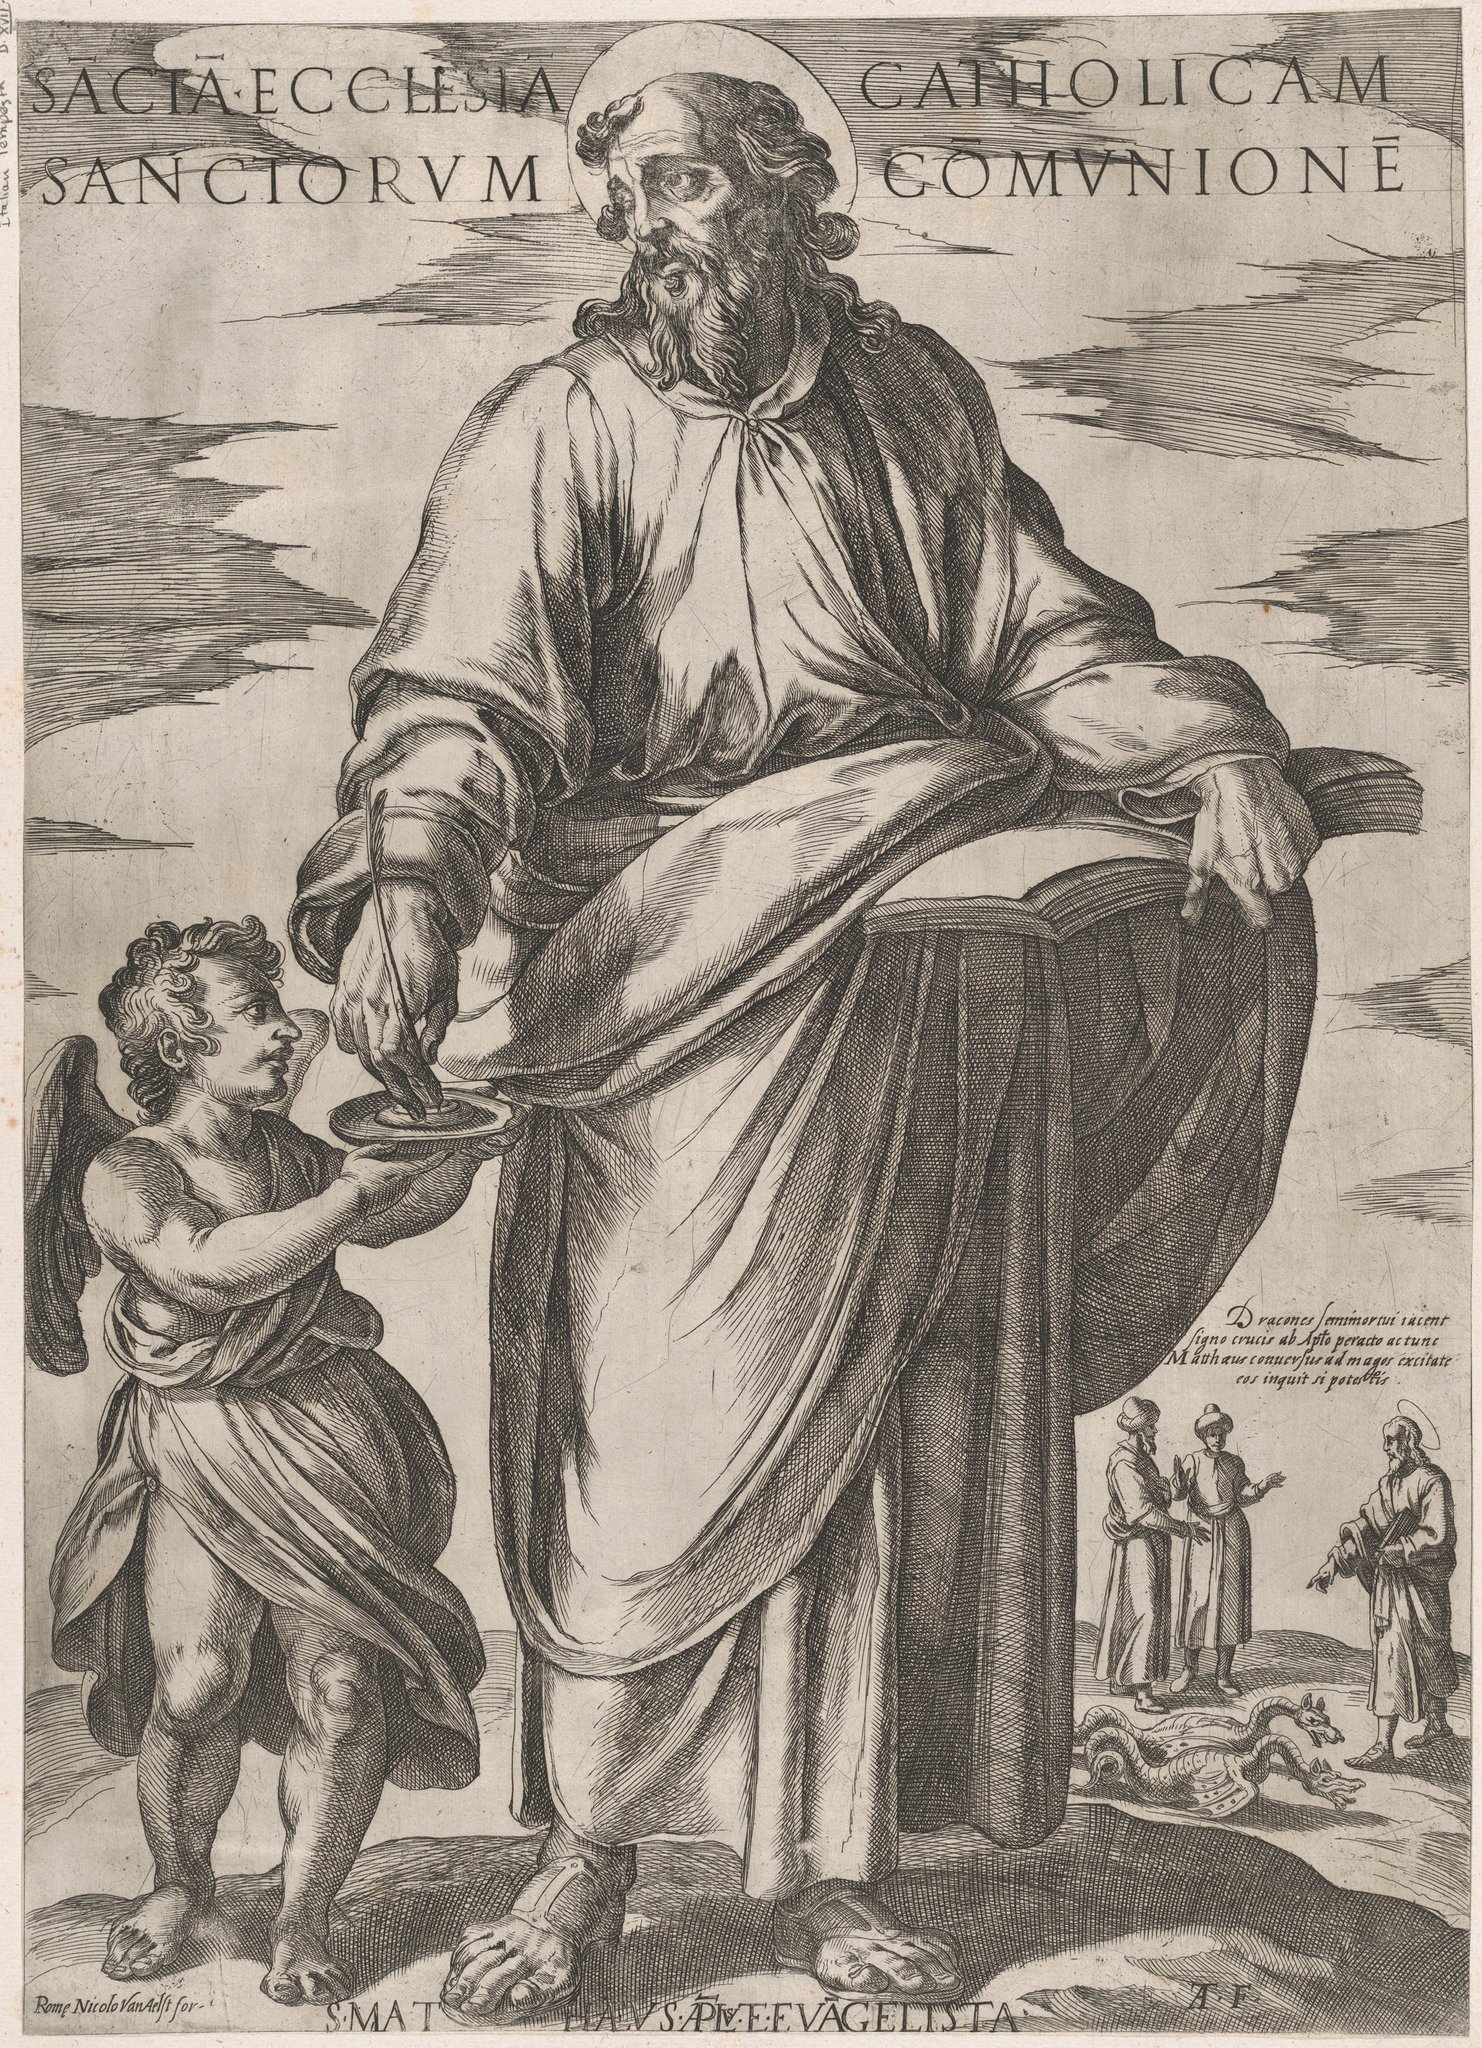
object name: print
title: St. Matthew, from 'Christ, Mary, and the Apostles'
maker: antonio tempesta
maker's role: artist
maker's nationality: italian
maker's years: 1555-1630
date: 1590-1610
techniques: etching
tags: saint matthew